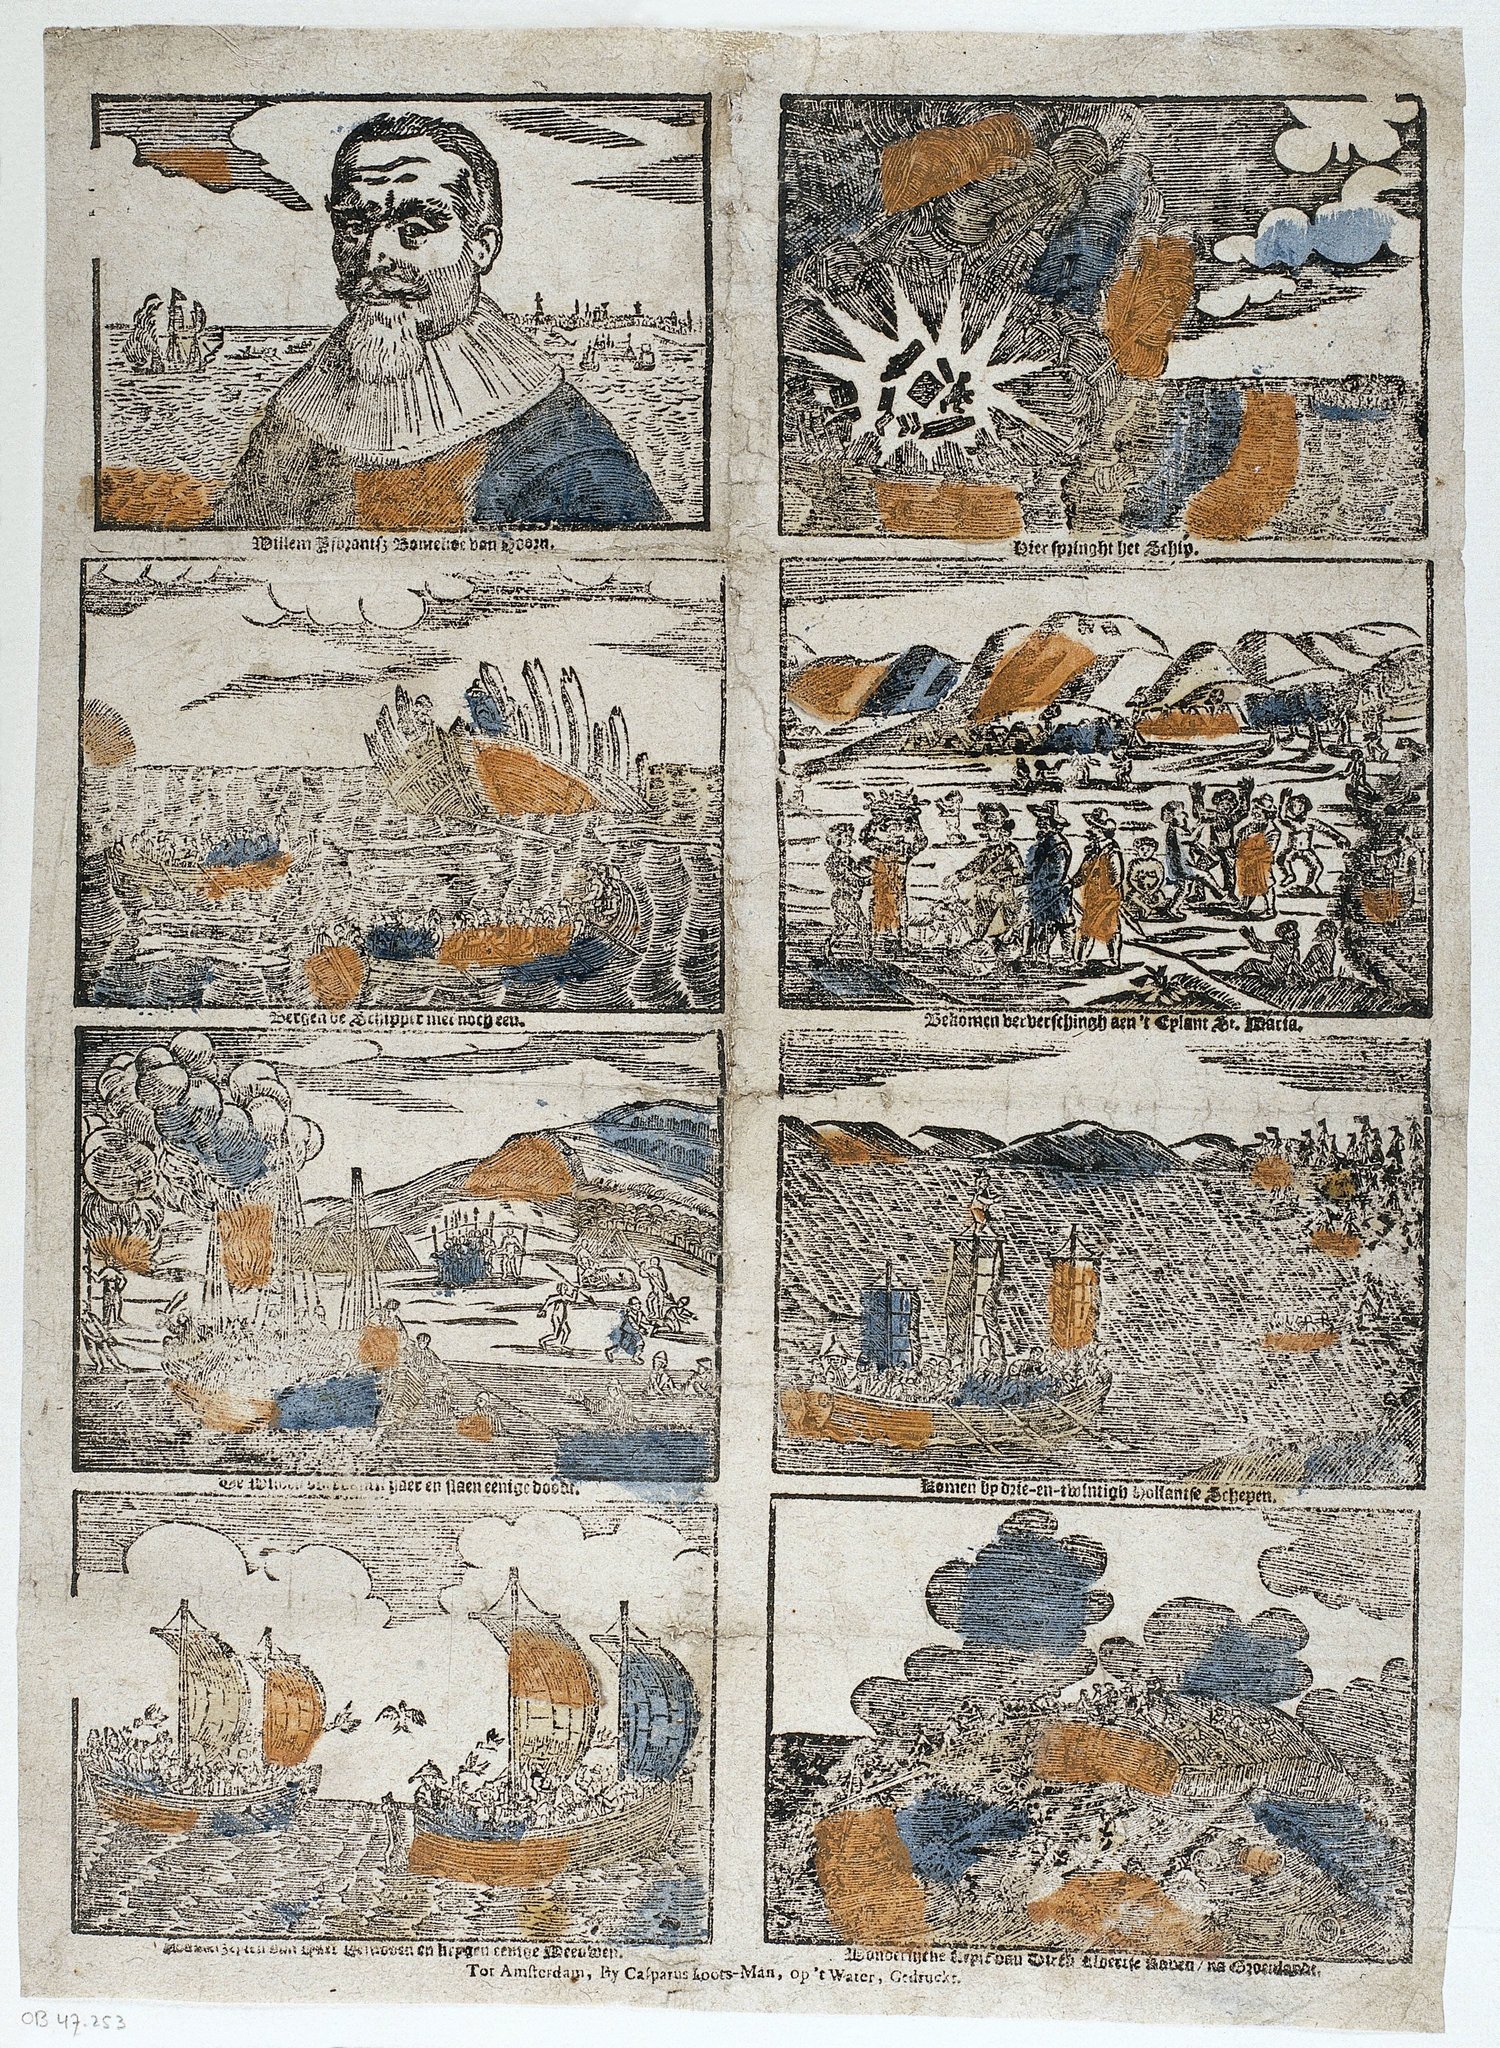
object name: print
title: Willem Ysbrantsz. Bontekoe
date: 1689-1711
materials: paper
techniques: colour, letterpress printing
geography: amsterdam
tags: hoorn (north holland), willem ysbrantsz. bontekoe, gunpowder disaster (+ sailing-ships), battle (+ naval force), ships (in general)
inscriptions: collector's mark: Lugt 2760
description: Blad met 8 voorstellingen van de avonturen van Willem Ysbrantsz. Bontekoe en zijn schip. Onder elke afbeelding een onderschrift.